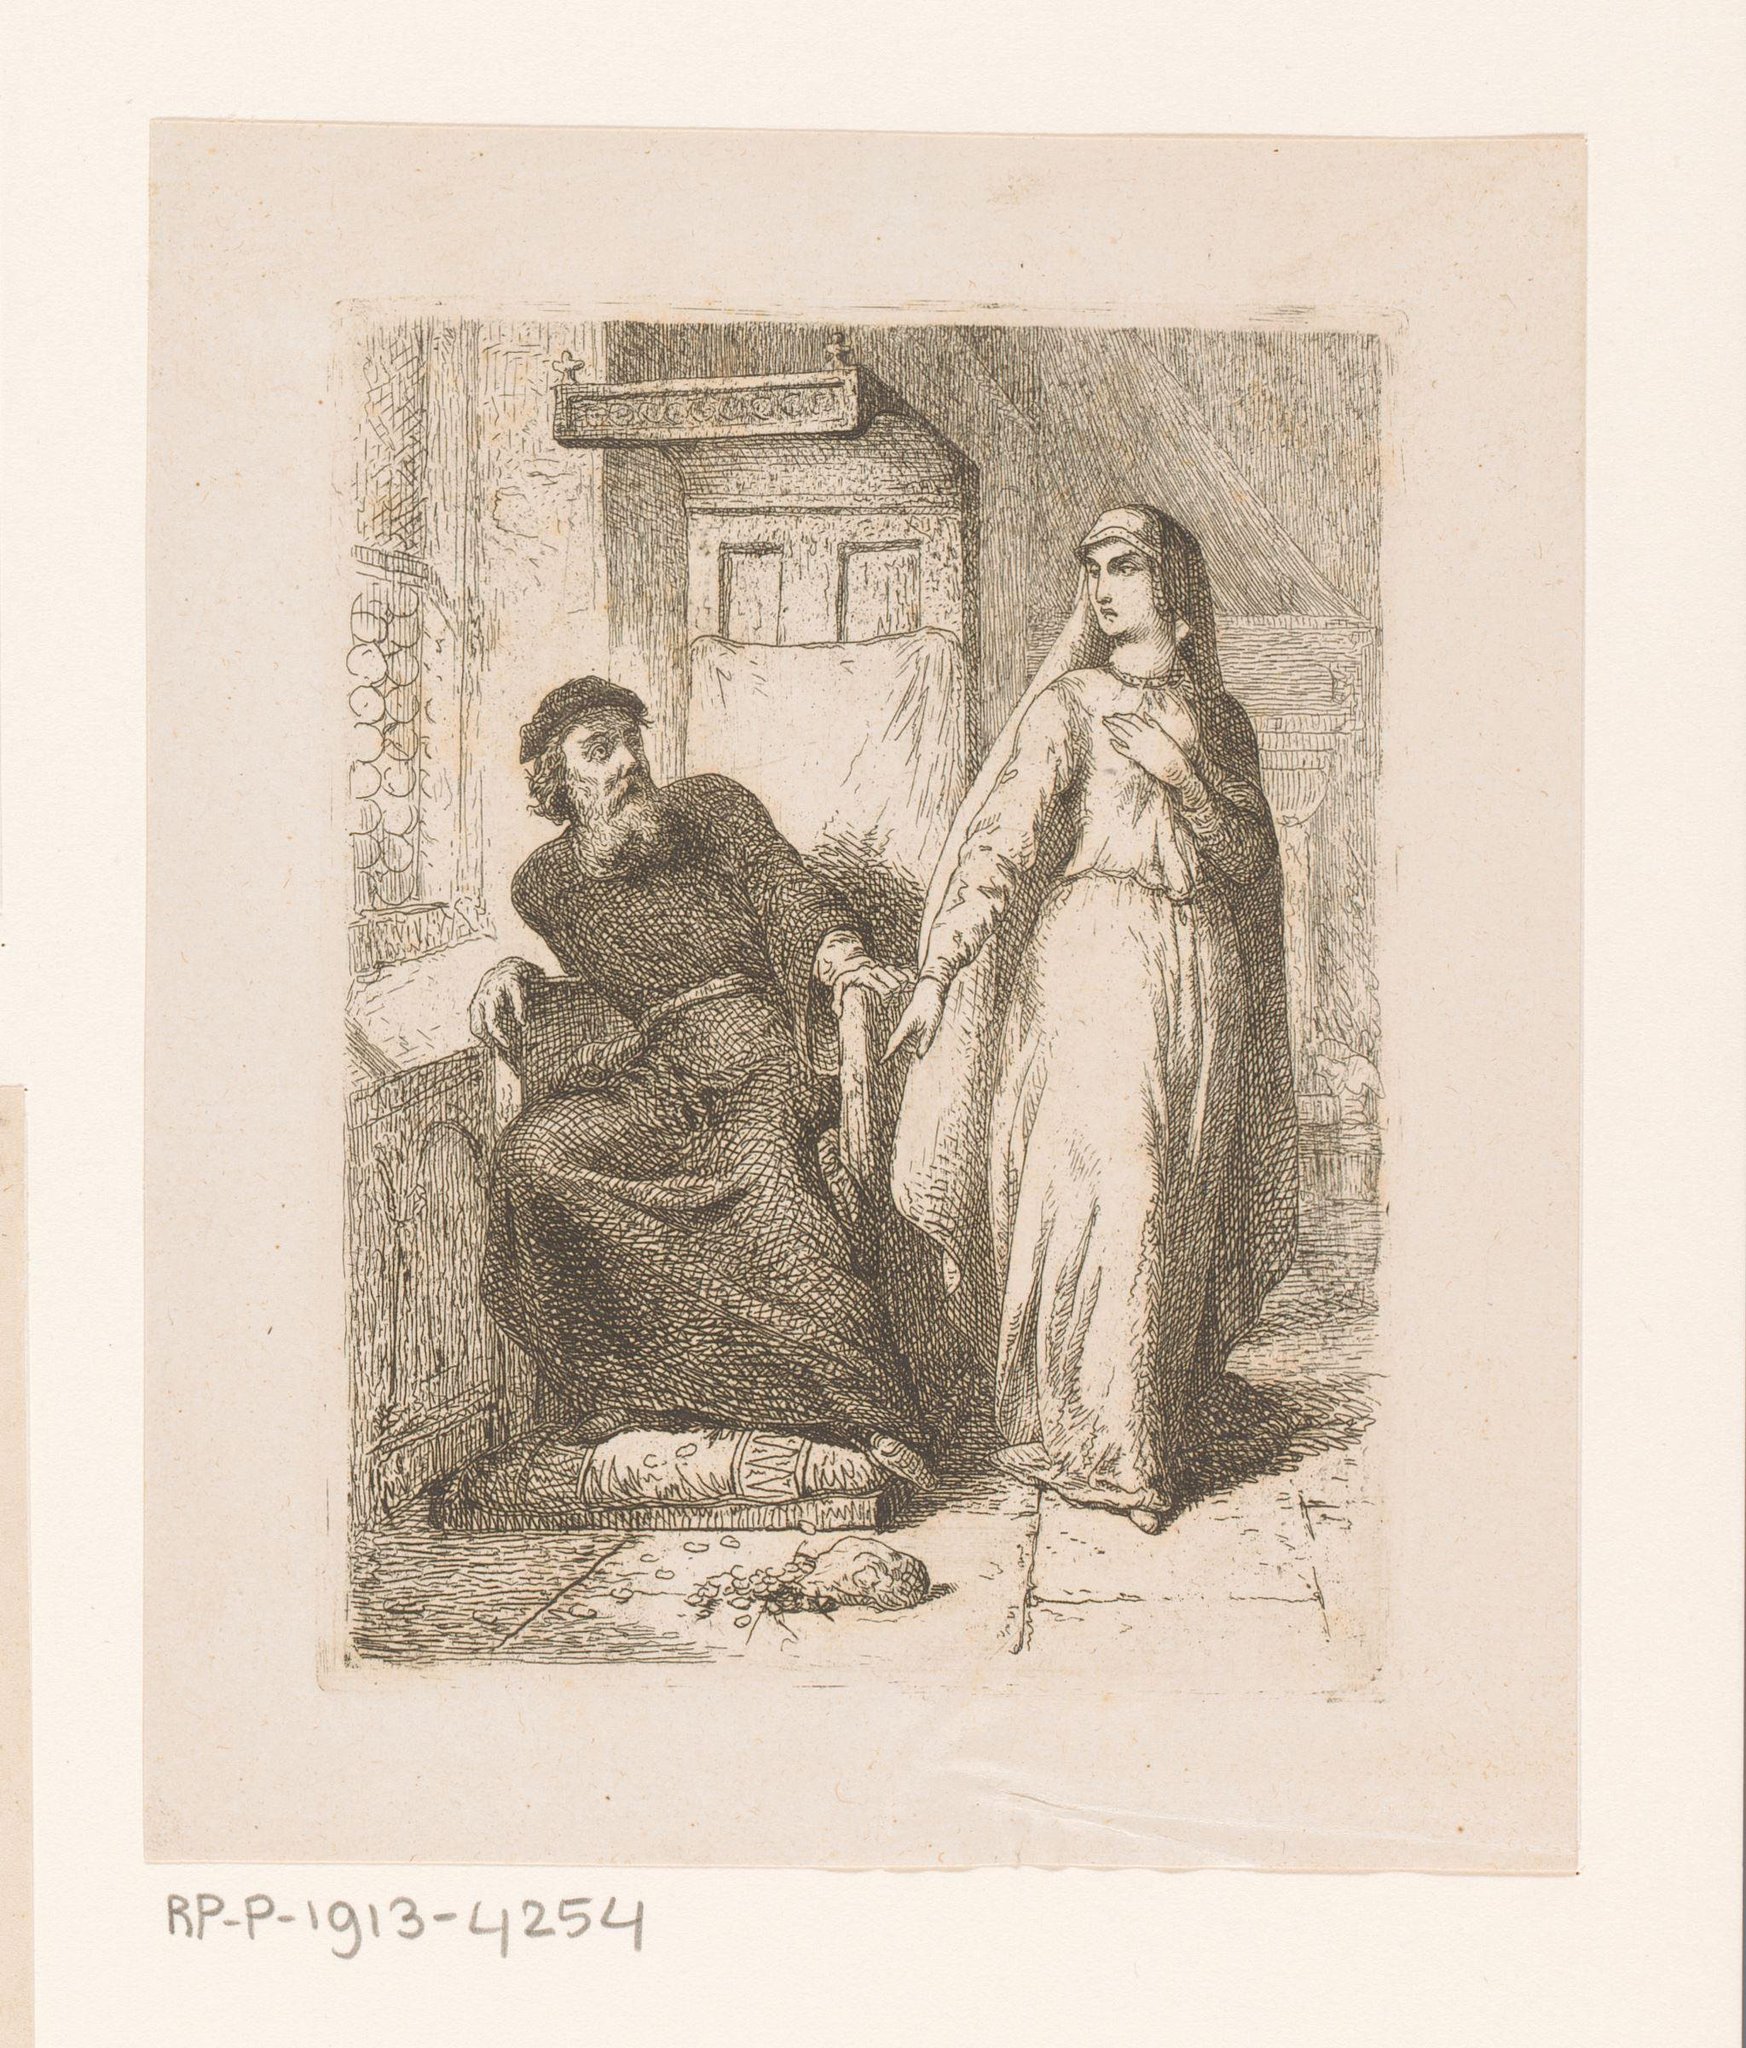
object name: print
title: Bruno en zijn dochter Laura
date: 1857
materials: paper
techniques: etching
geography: amsterdam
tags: dowry, widow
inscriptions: collector's mark: Lugt 1485, collector's mark: Lugt 2228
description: Prent uit: Horst, J.J. van der. Vader Bruno, de kluizenaar van Overveen. Amsterdam: C.L. van Langenhuysen, 1857.